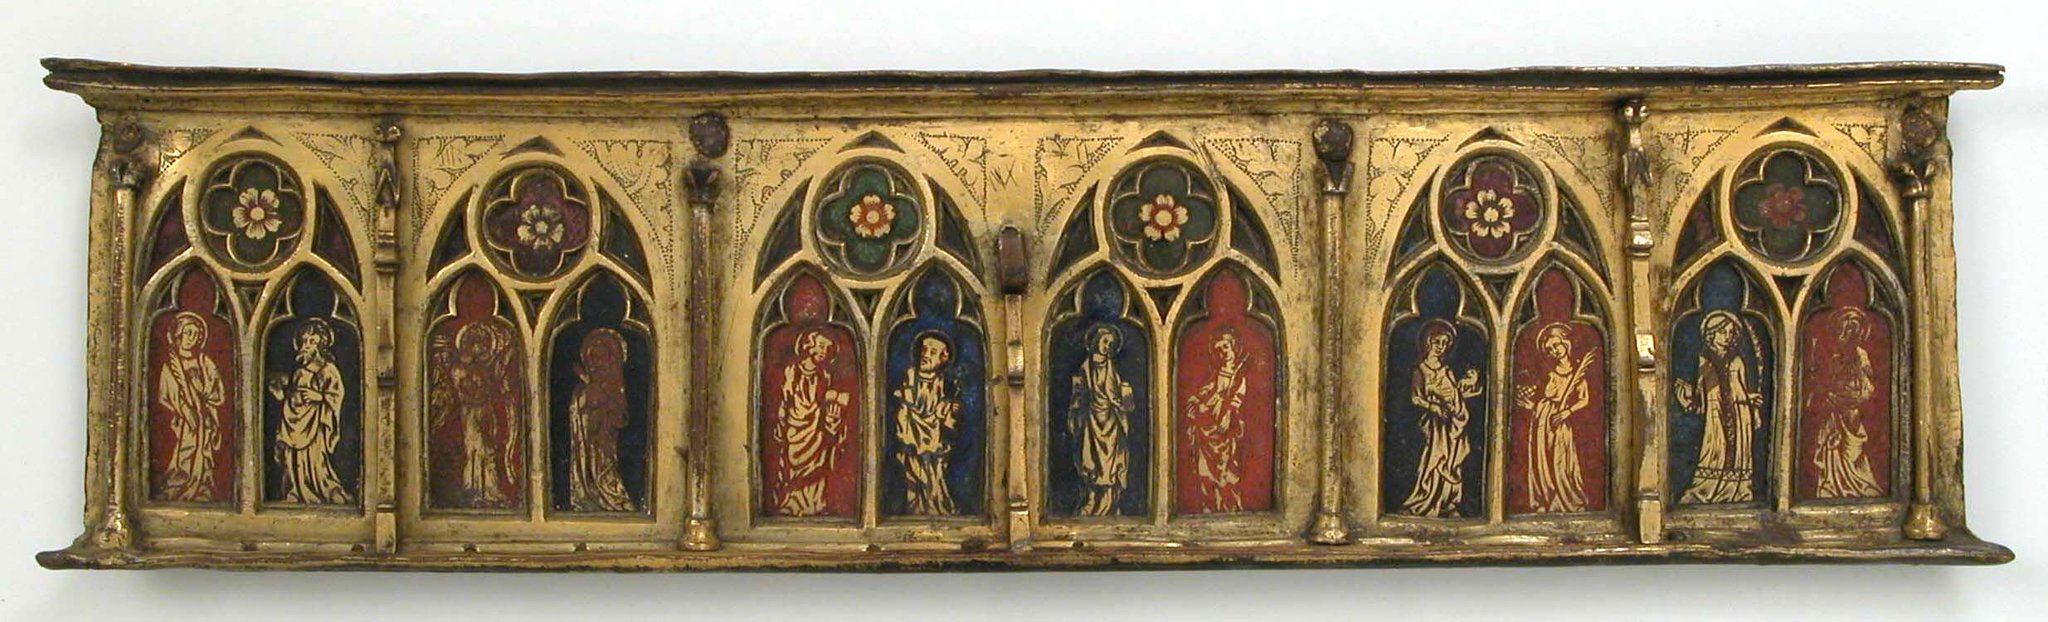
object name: plaque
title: Plaque with Six Inset Panels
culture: french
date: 1301-1400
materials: gilt copper, enamel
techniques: enamel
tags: men,flowers